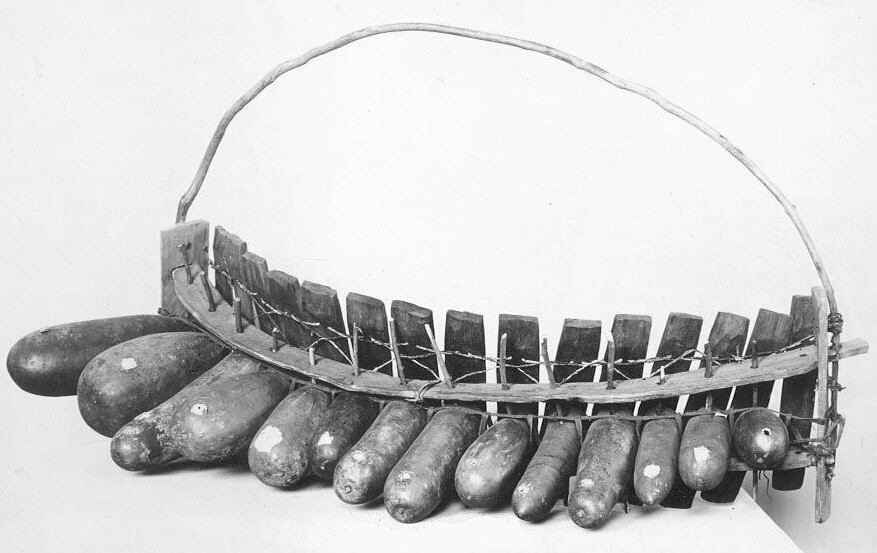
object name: xylophone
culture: south african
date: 1801-1900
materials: leather, wood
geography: south africa